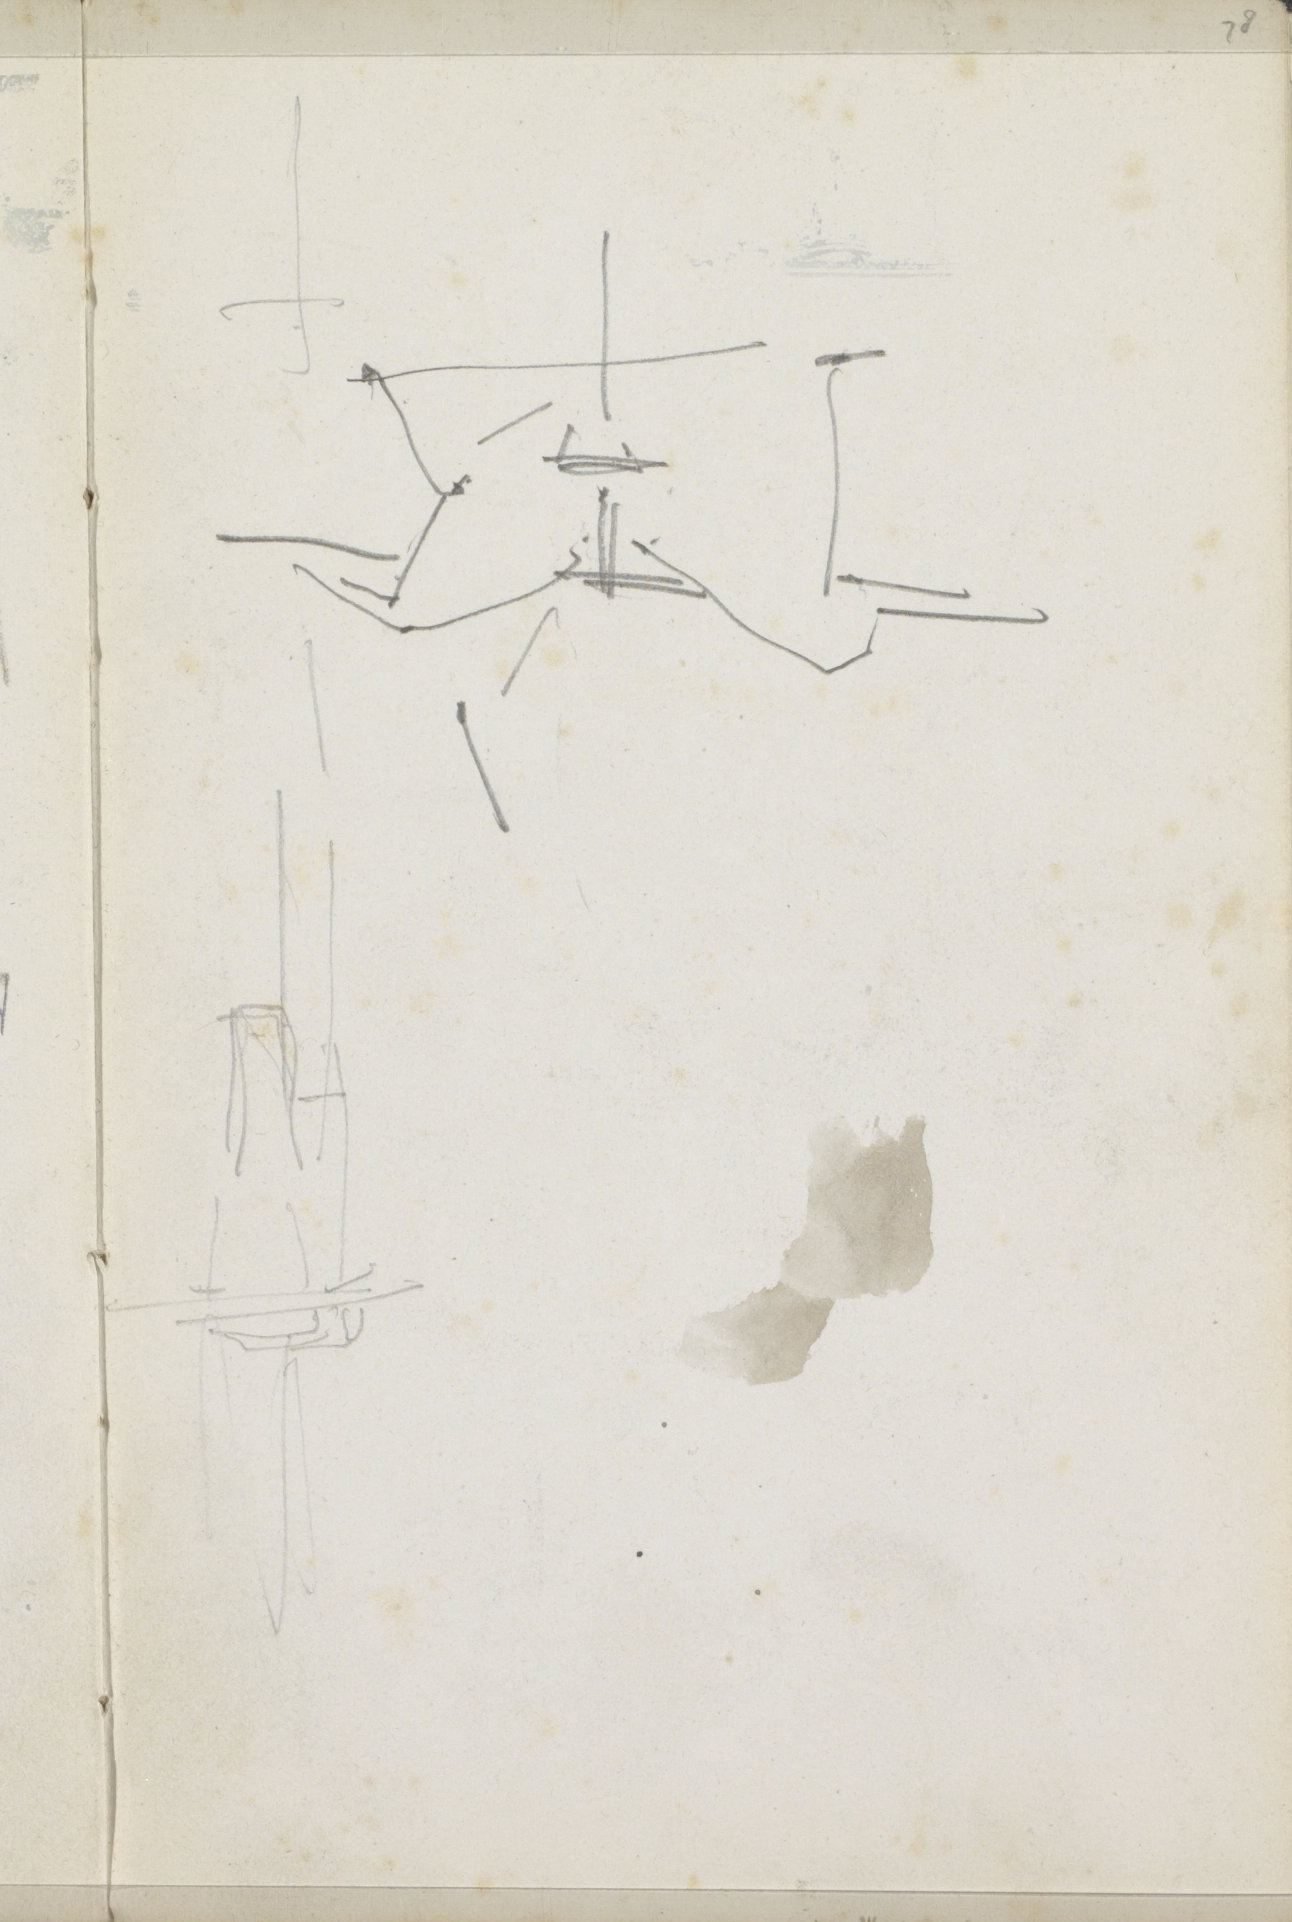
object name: sketchbook leaf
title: Studies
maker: george hendrik breitner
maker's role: draughtsman, painter, print maker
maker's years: 1857-1923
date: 1880-1882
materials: paper, pencil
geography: south holland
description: Pagina 78 uit een schetsboek met 72 bladen.